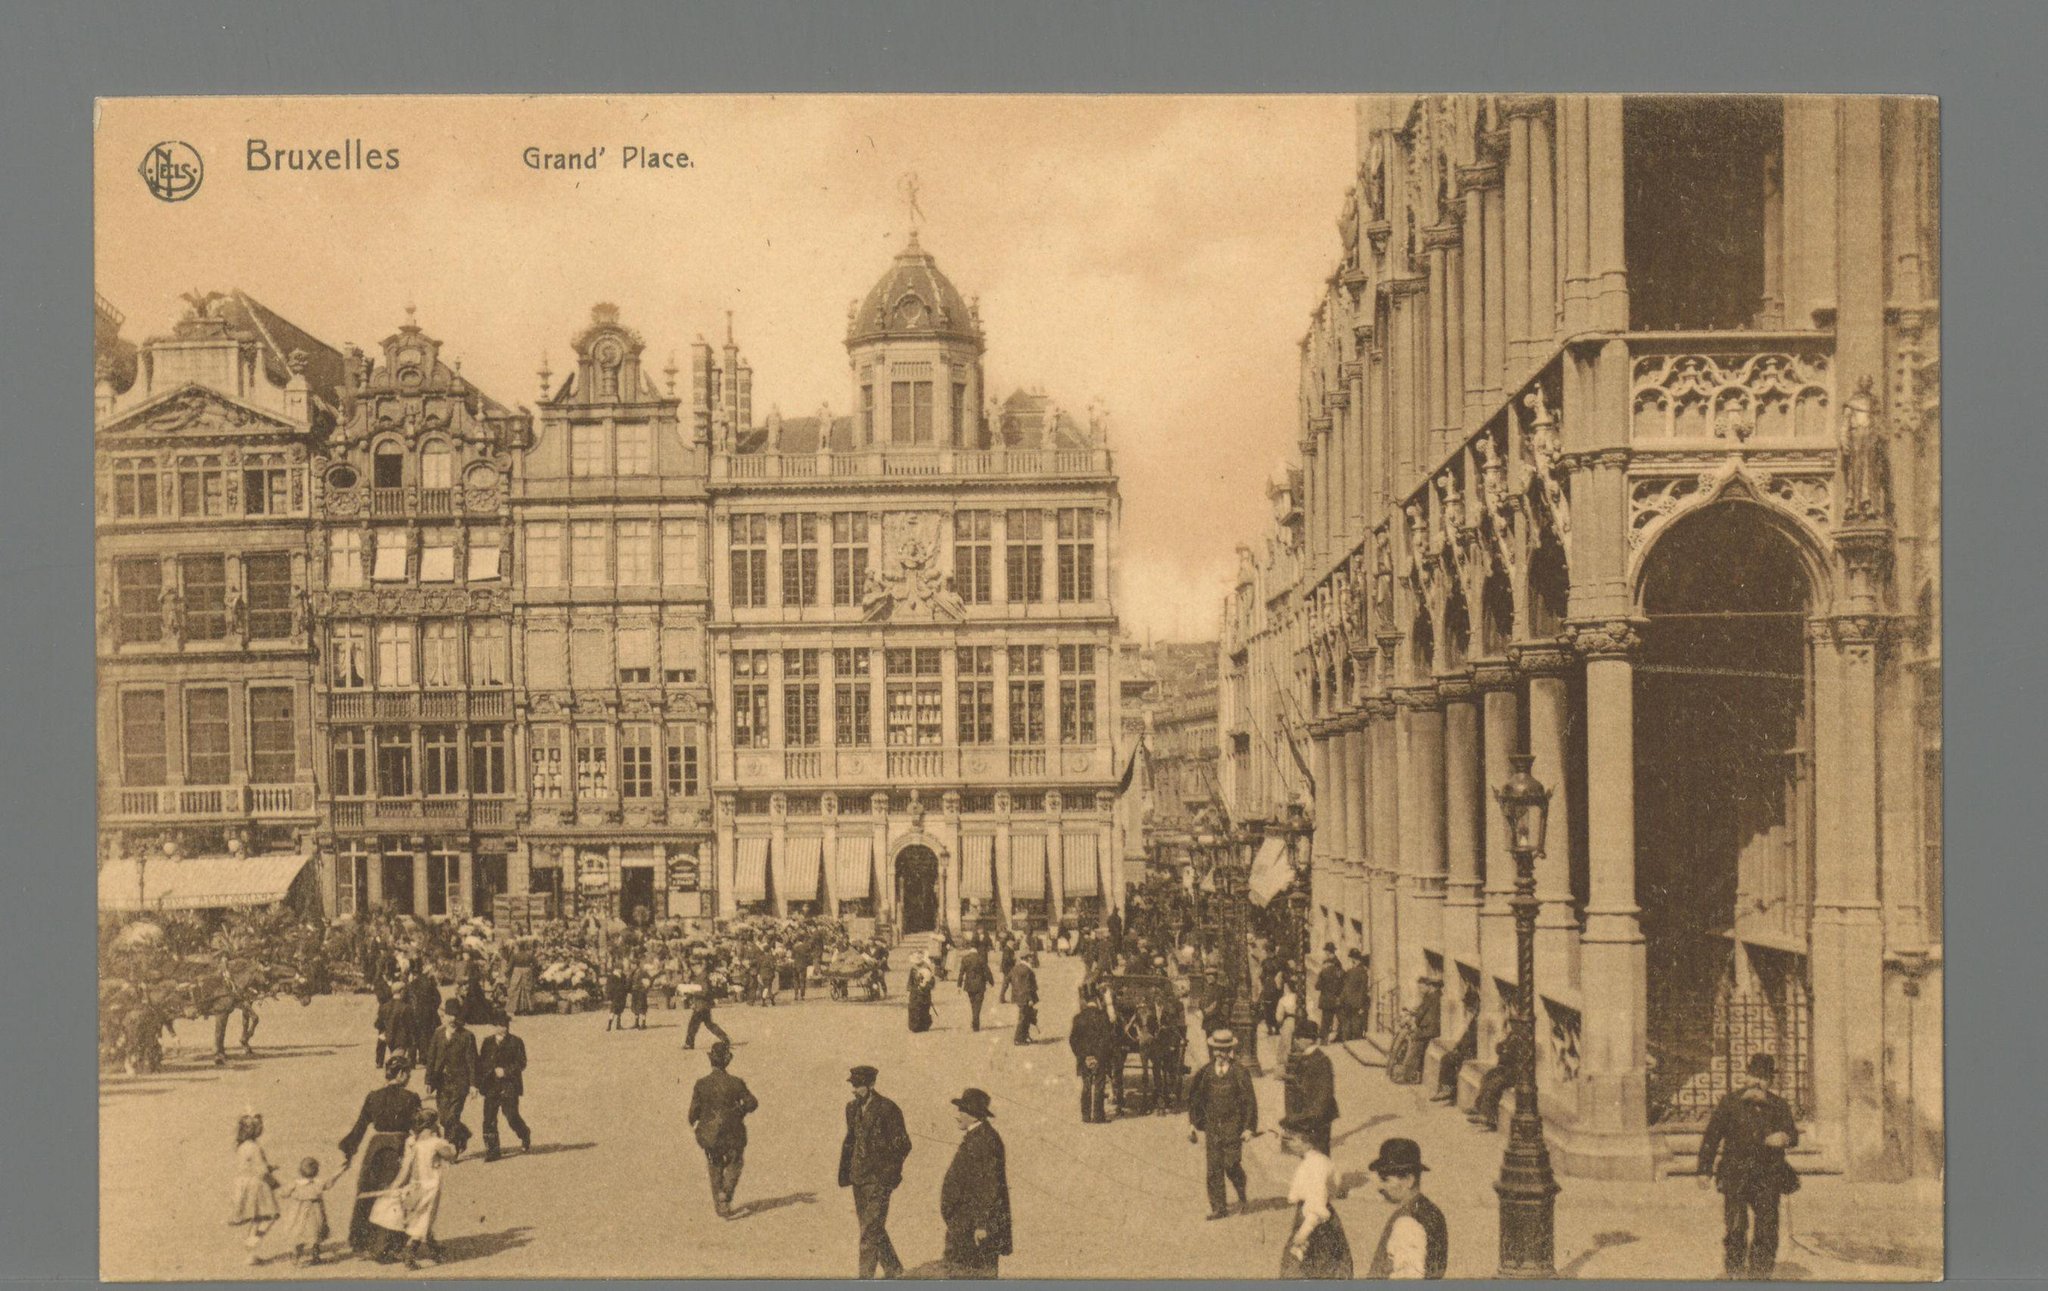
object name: ansichtkaart, prentbriefkaart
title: Bruxelles. Grand'Place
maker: Anonymous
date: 1907-1913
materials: cardboard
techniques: photograph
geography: brussels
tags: square, place, circus, etc., city-view, and landscape with man-made constructions (+ city(-scape) with figures, staffage)